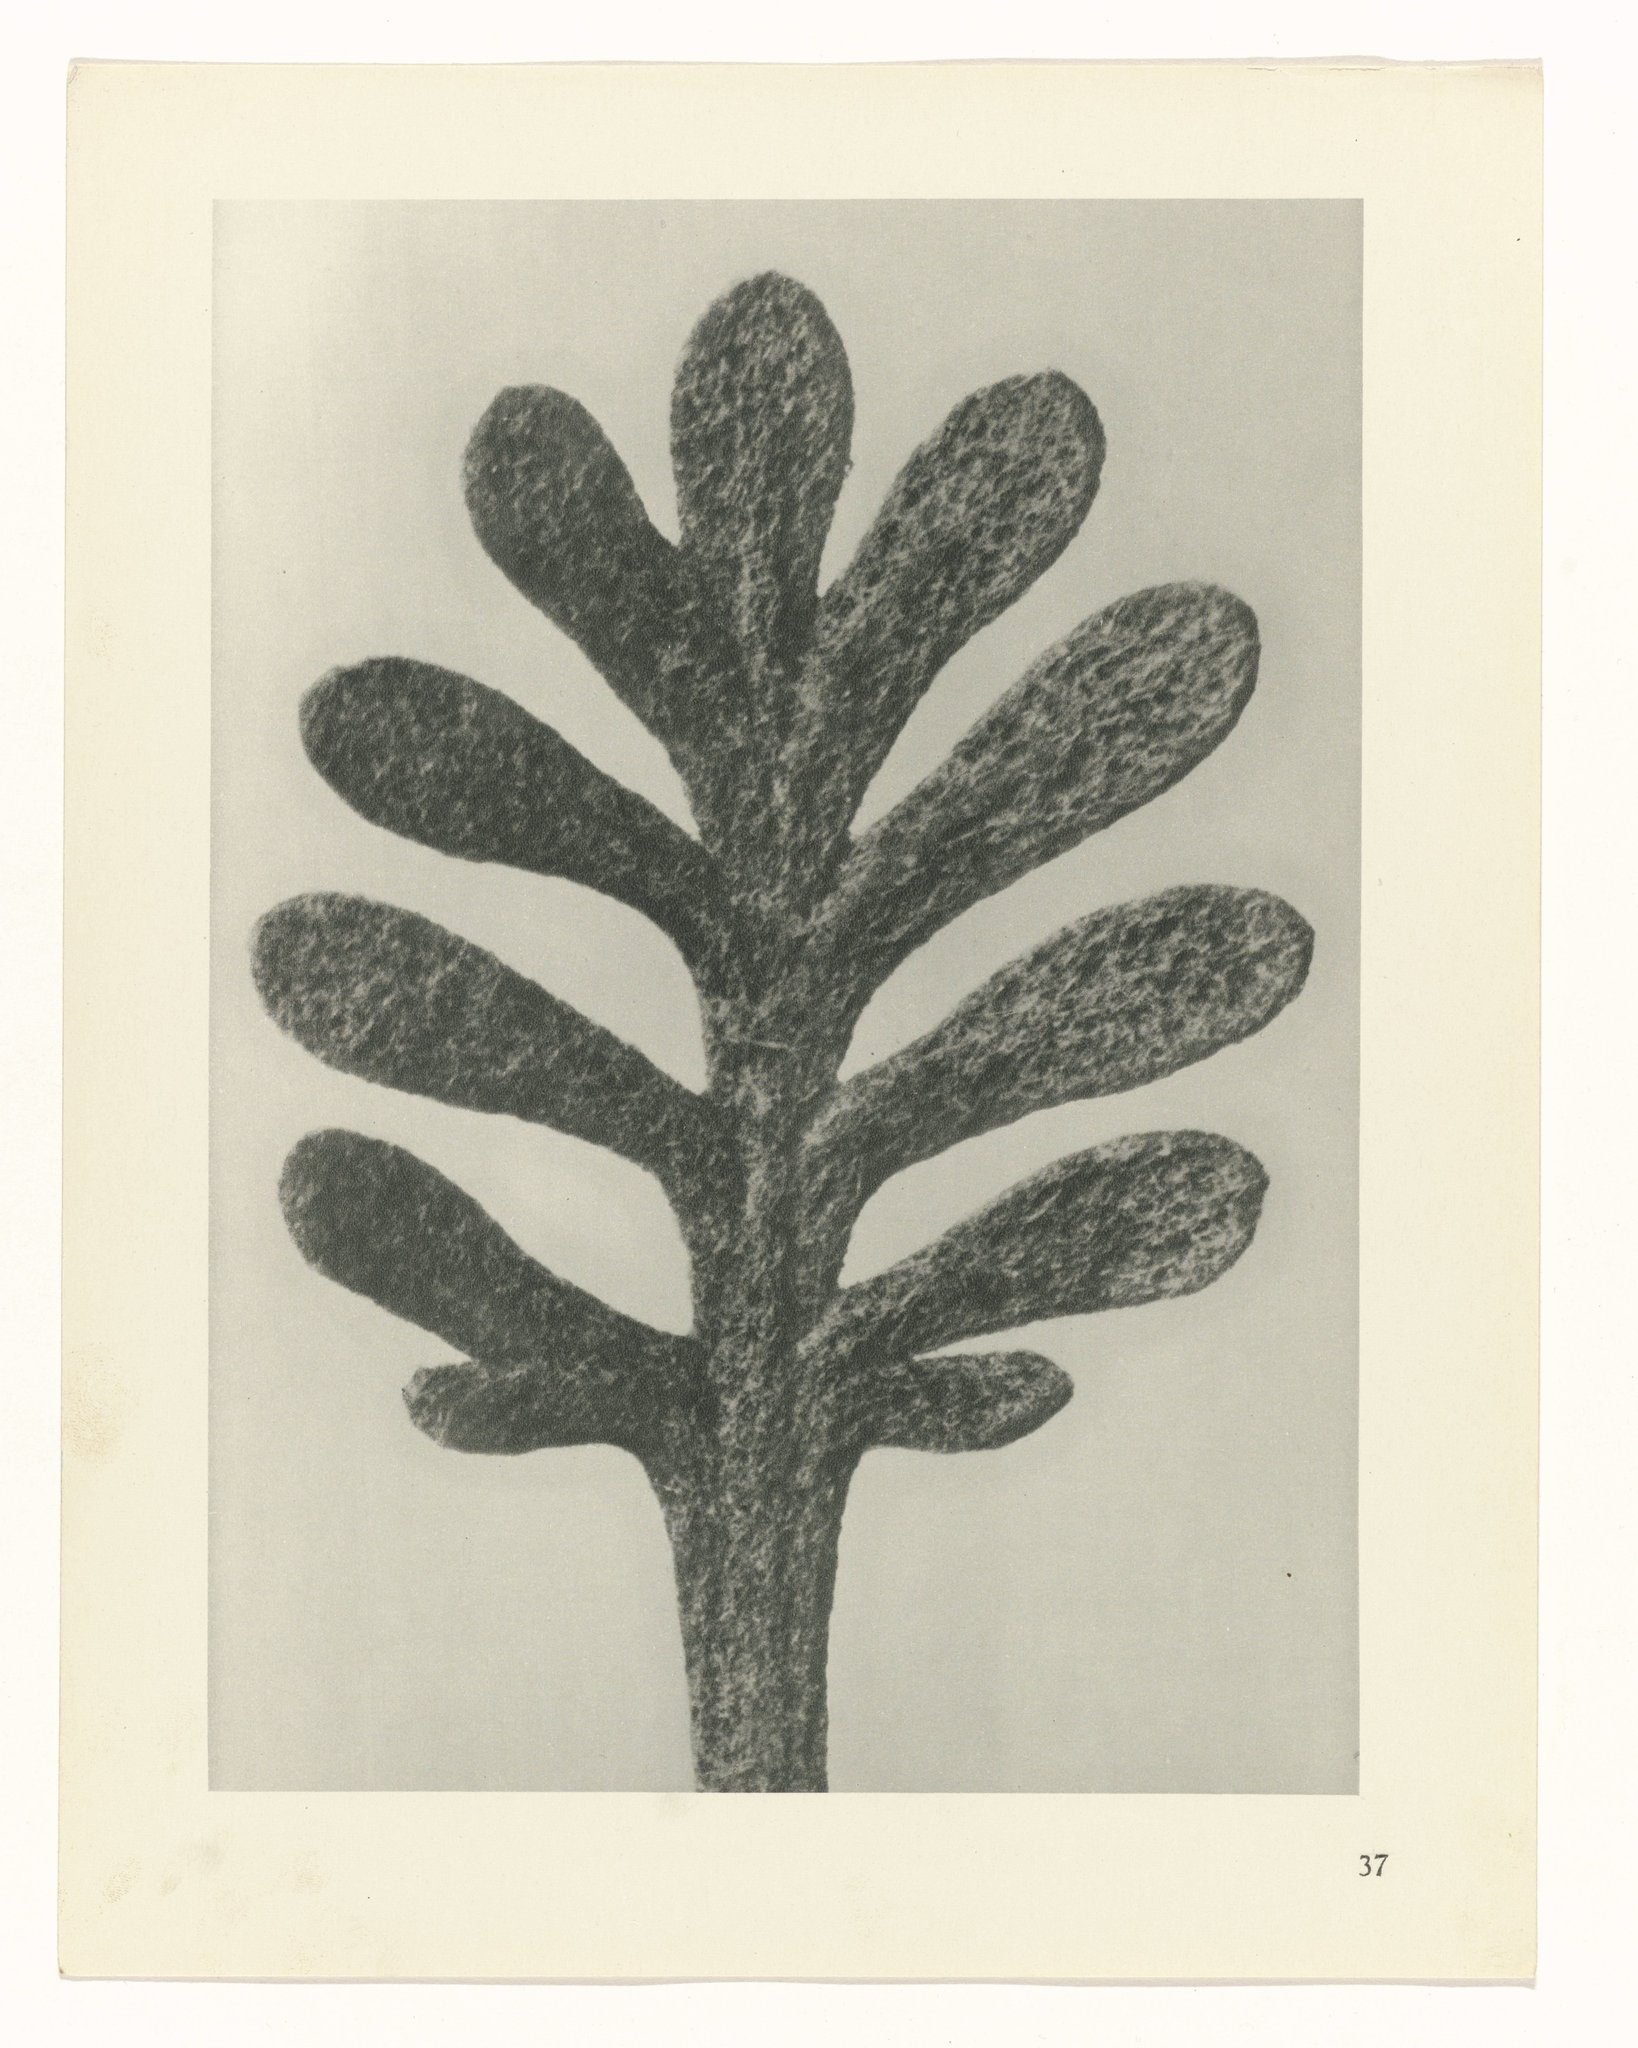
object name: photograph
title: Plant Studies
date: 1928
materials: ink, paper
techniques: rotogravure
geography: berlin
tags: plants (in general)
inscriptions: number: ‘37’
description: facher Vergrößerung. Afkomstig uit losbladige uitgave.